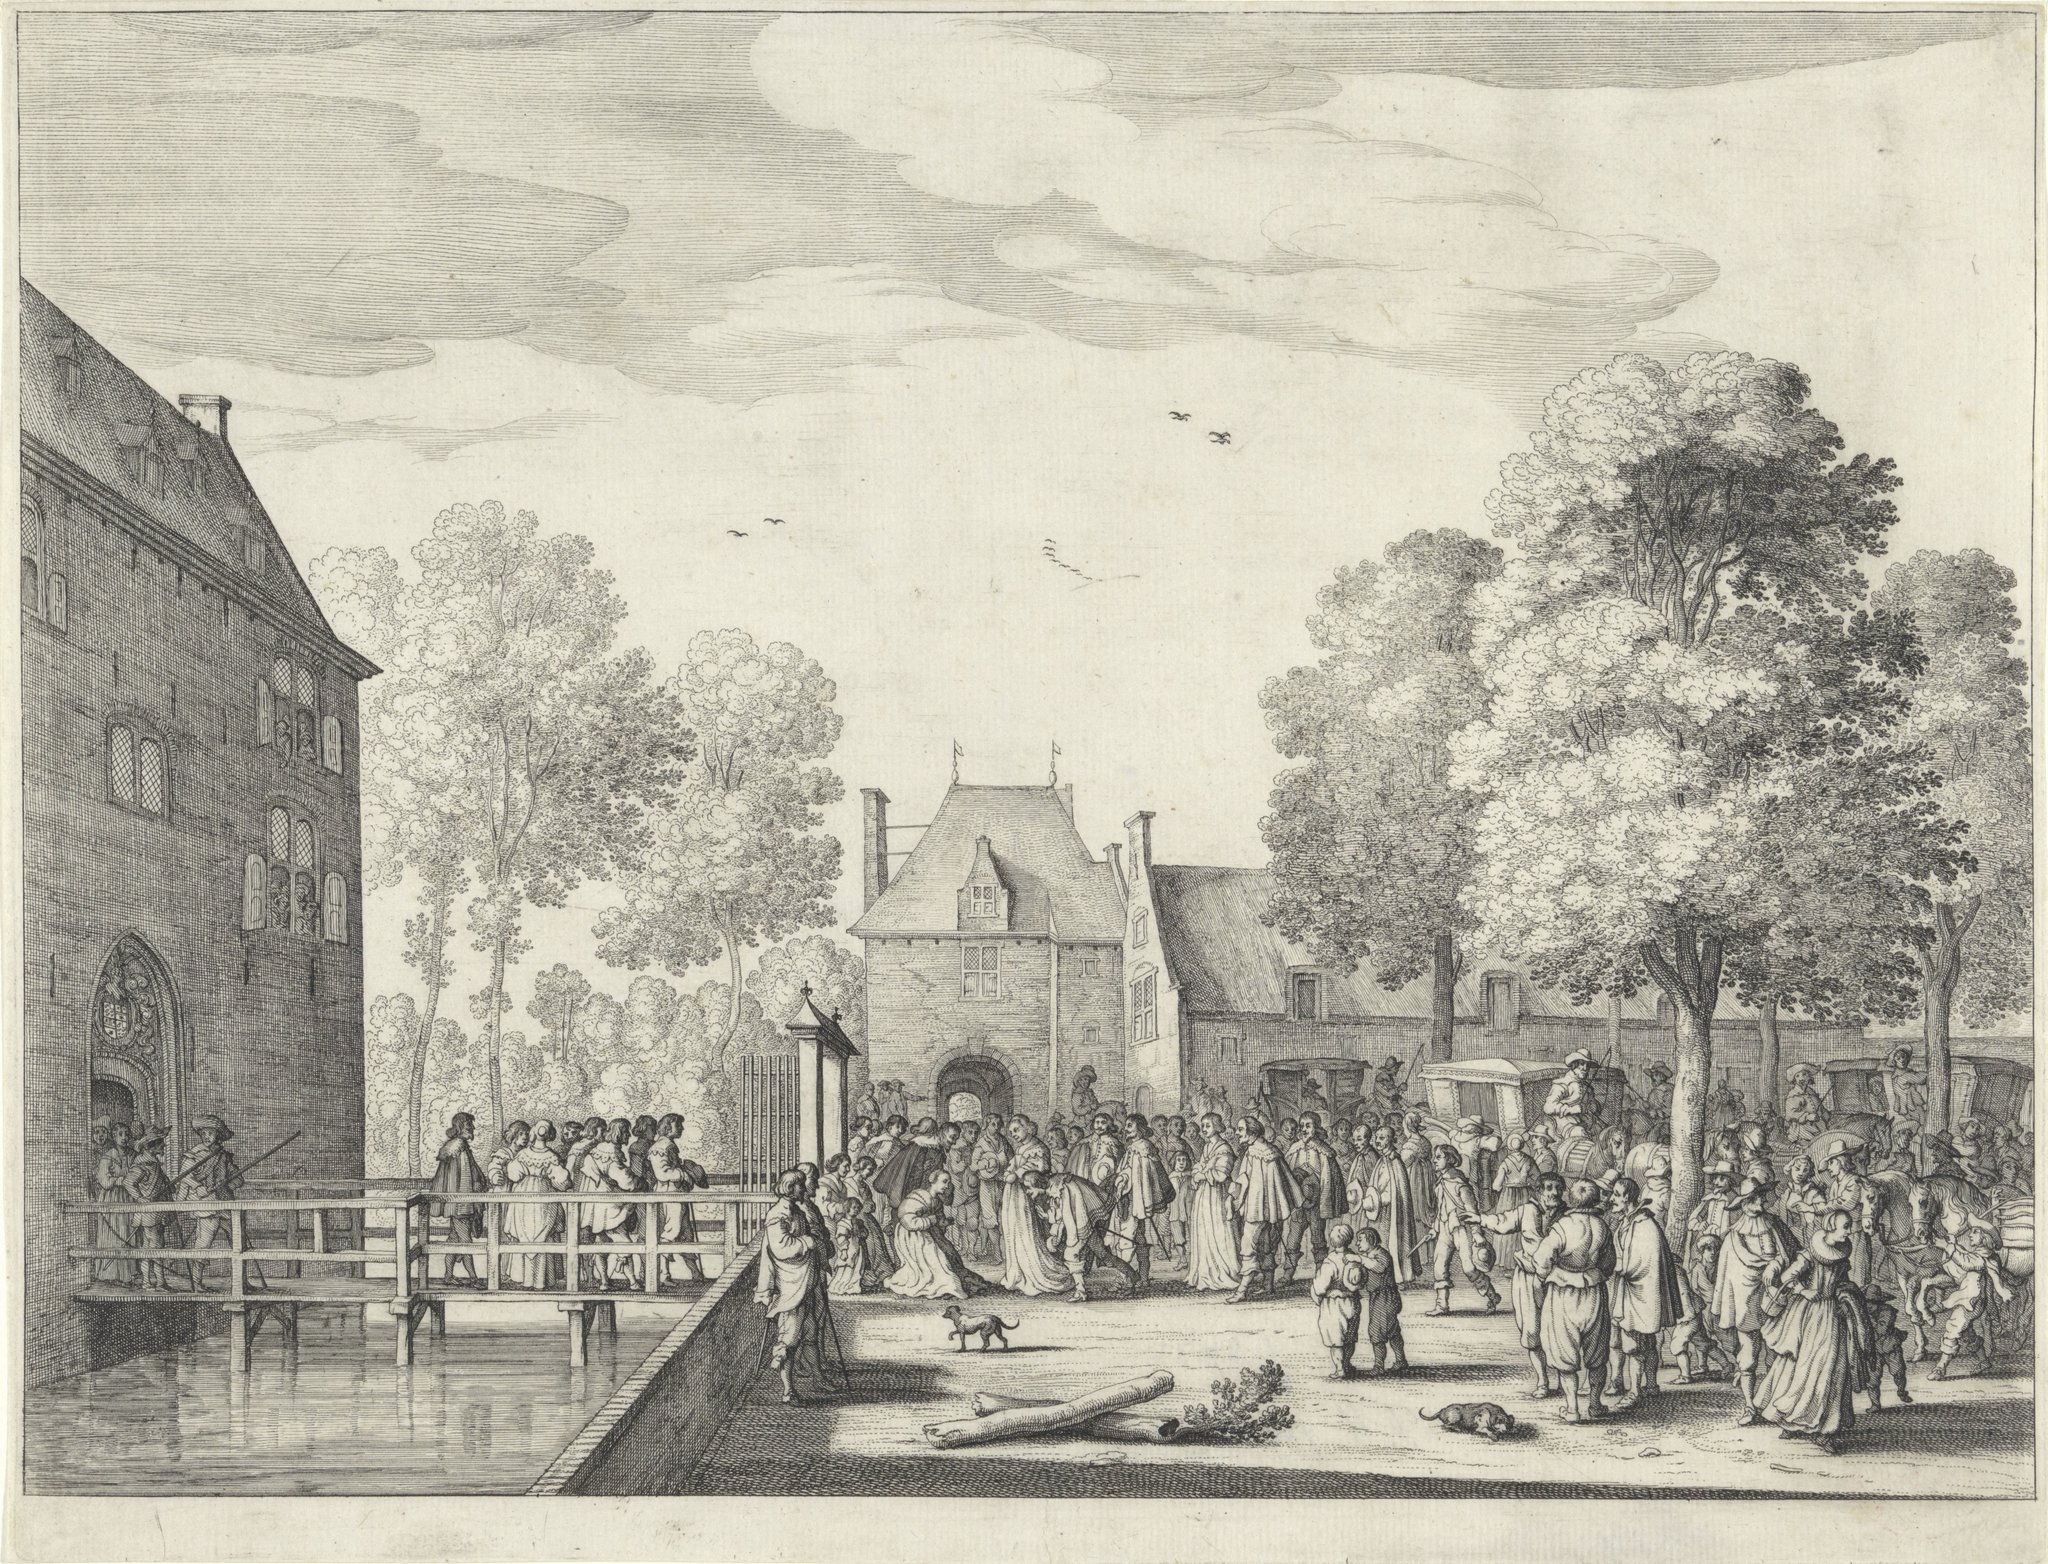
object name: print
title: Bezoek van koningin Henrietta Maria aan Adriaen Pauw op het Slot te Heemstede, 1642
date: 1642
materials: paper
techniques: etching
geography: amsterdam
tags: henriëtta maria van frankrijk (koningin van engeland, schotland en ierland), william ii (prince of orange), amsterdam, the hague, politician, adriaen pauw (1585-1653), visiting; receiving guests; elegant company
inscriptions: collector's mark: Lugt 240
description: Het bezoek van de Engelse koningin Henrietta Maria en prins Willem II aan Adriaen Pauw op het Slot te Heemstede, 8 september 1642. Het gezelschap wordt bij de poort ontvangen, links het slot.